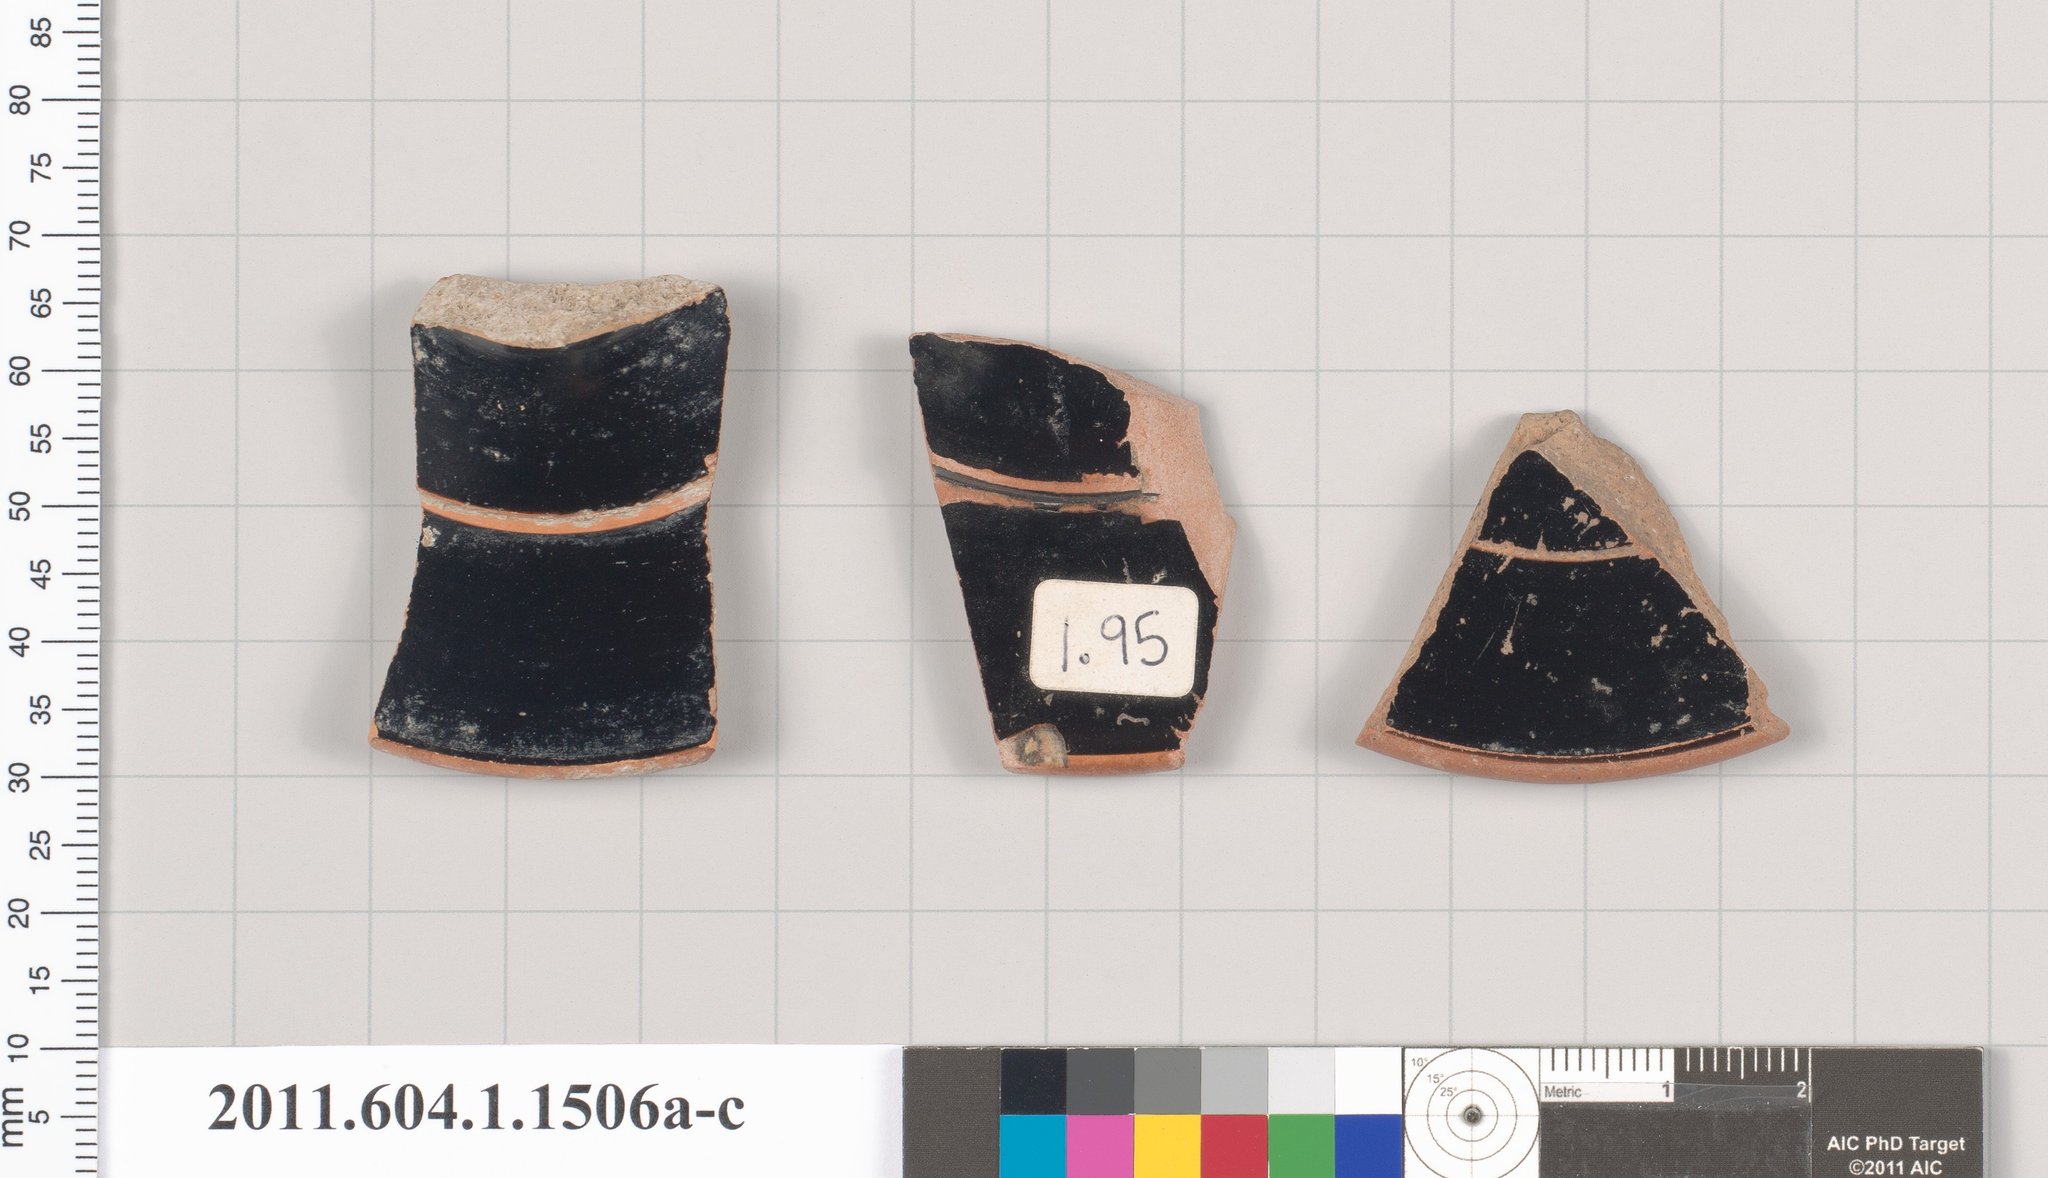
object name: kylix fragment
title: Terracotta fragments of kylikes (drinking cups)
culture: greek, attic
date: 500-401 BCE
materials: terracotta